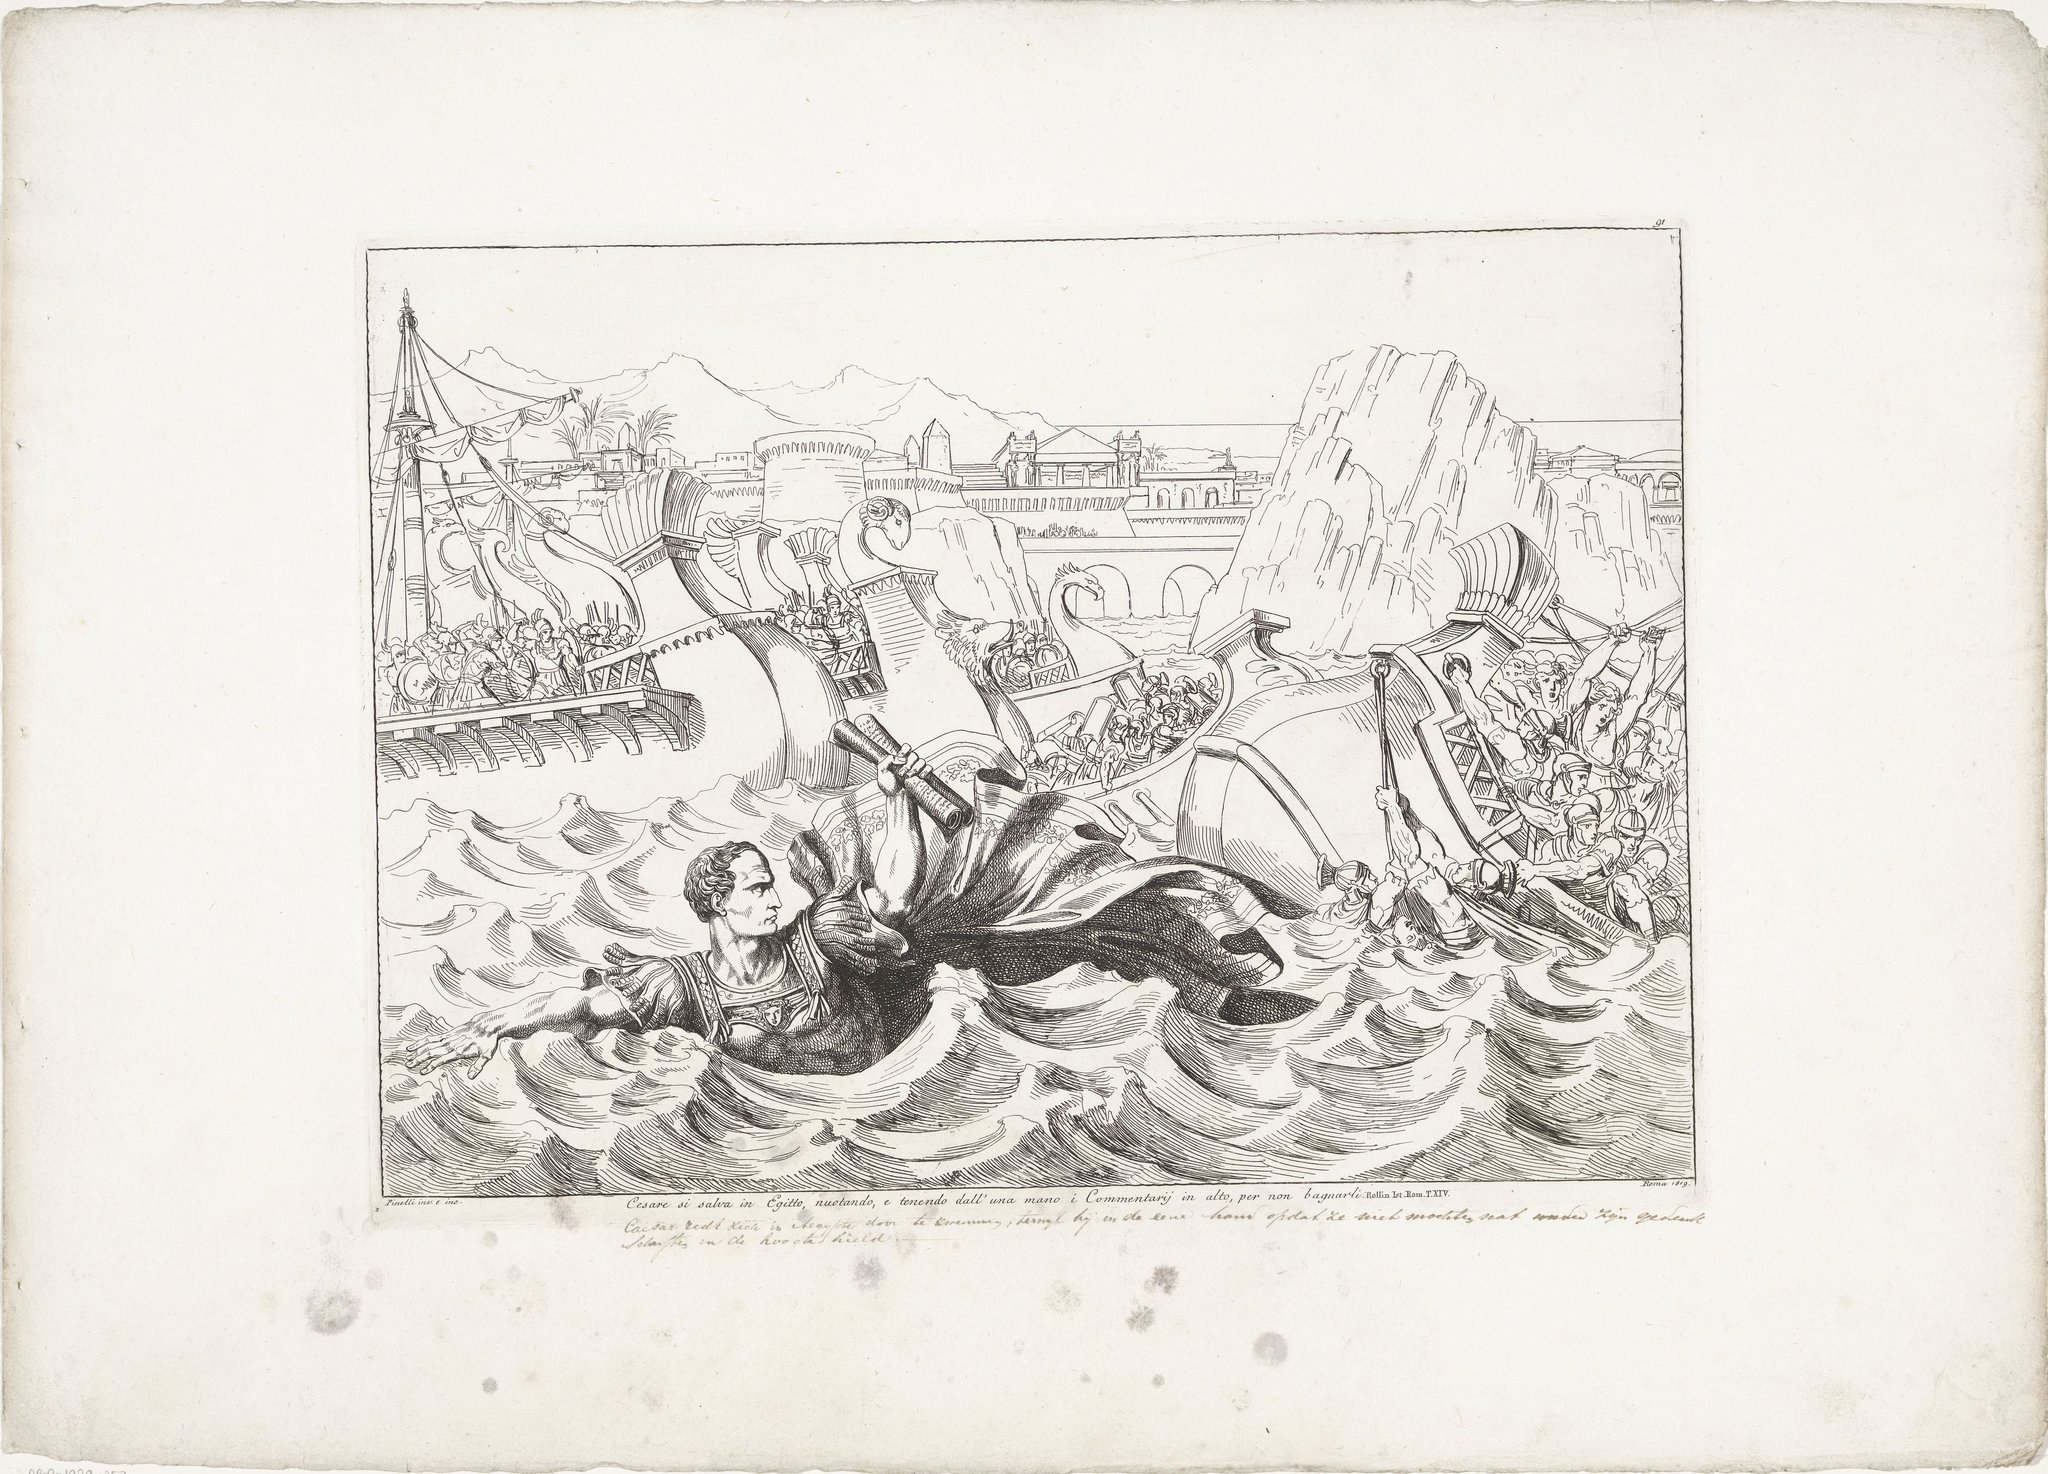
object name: print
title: Cesare si salva in Egitto, nuotando, e tenendo dall´ una mano i Commentarij in alto, per non bagnarli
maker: bartolomeo pinelli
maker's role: draughtsman, print maker, sculptor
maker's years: 1781-1835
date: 1819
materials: paper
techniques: etching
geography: rome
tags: (story of) c. julius caesar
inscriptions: collector's mark: Lugt 2228, inscription: ‘Caesar redt zich in Aegypte door te zwemmen, terwijl hij in de eene hand opdat ze niet mochten nat worden zijn...’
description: Julius Caesar zwemt voor de kust van Egypte om zichzelf in veiligheid te brengen. Met zijn ene hand houdt hij ondertussen tekstrollen droog boven het water.